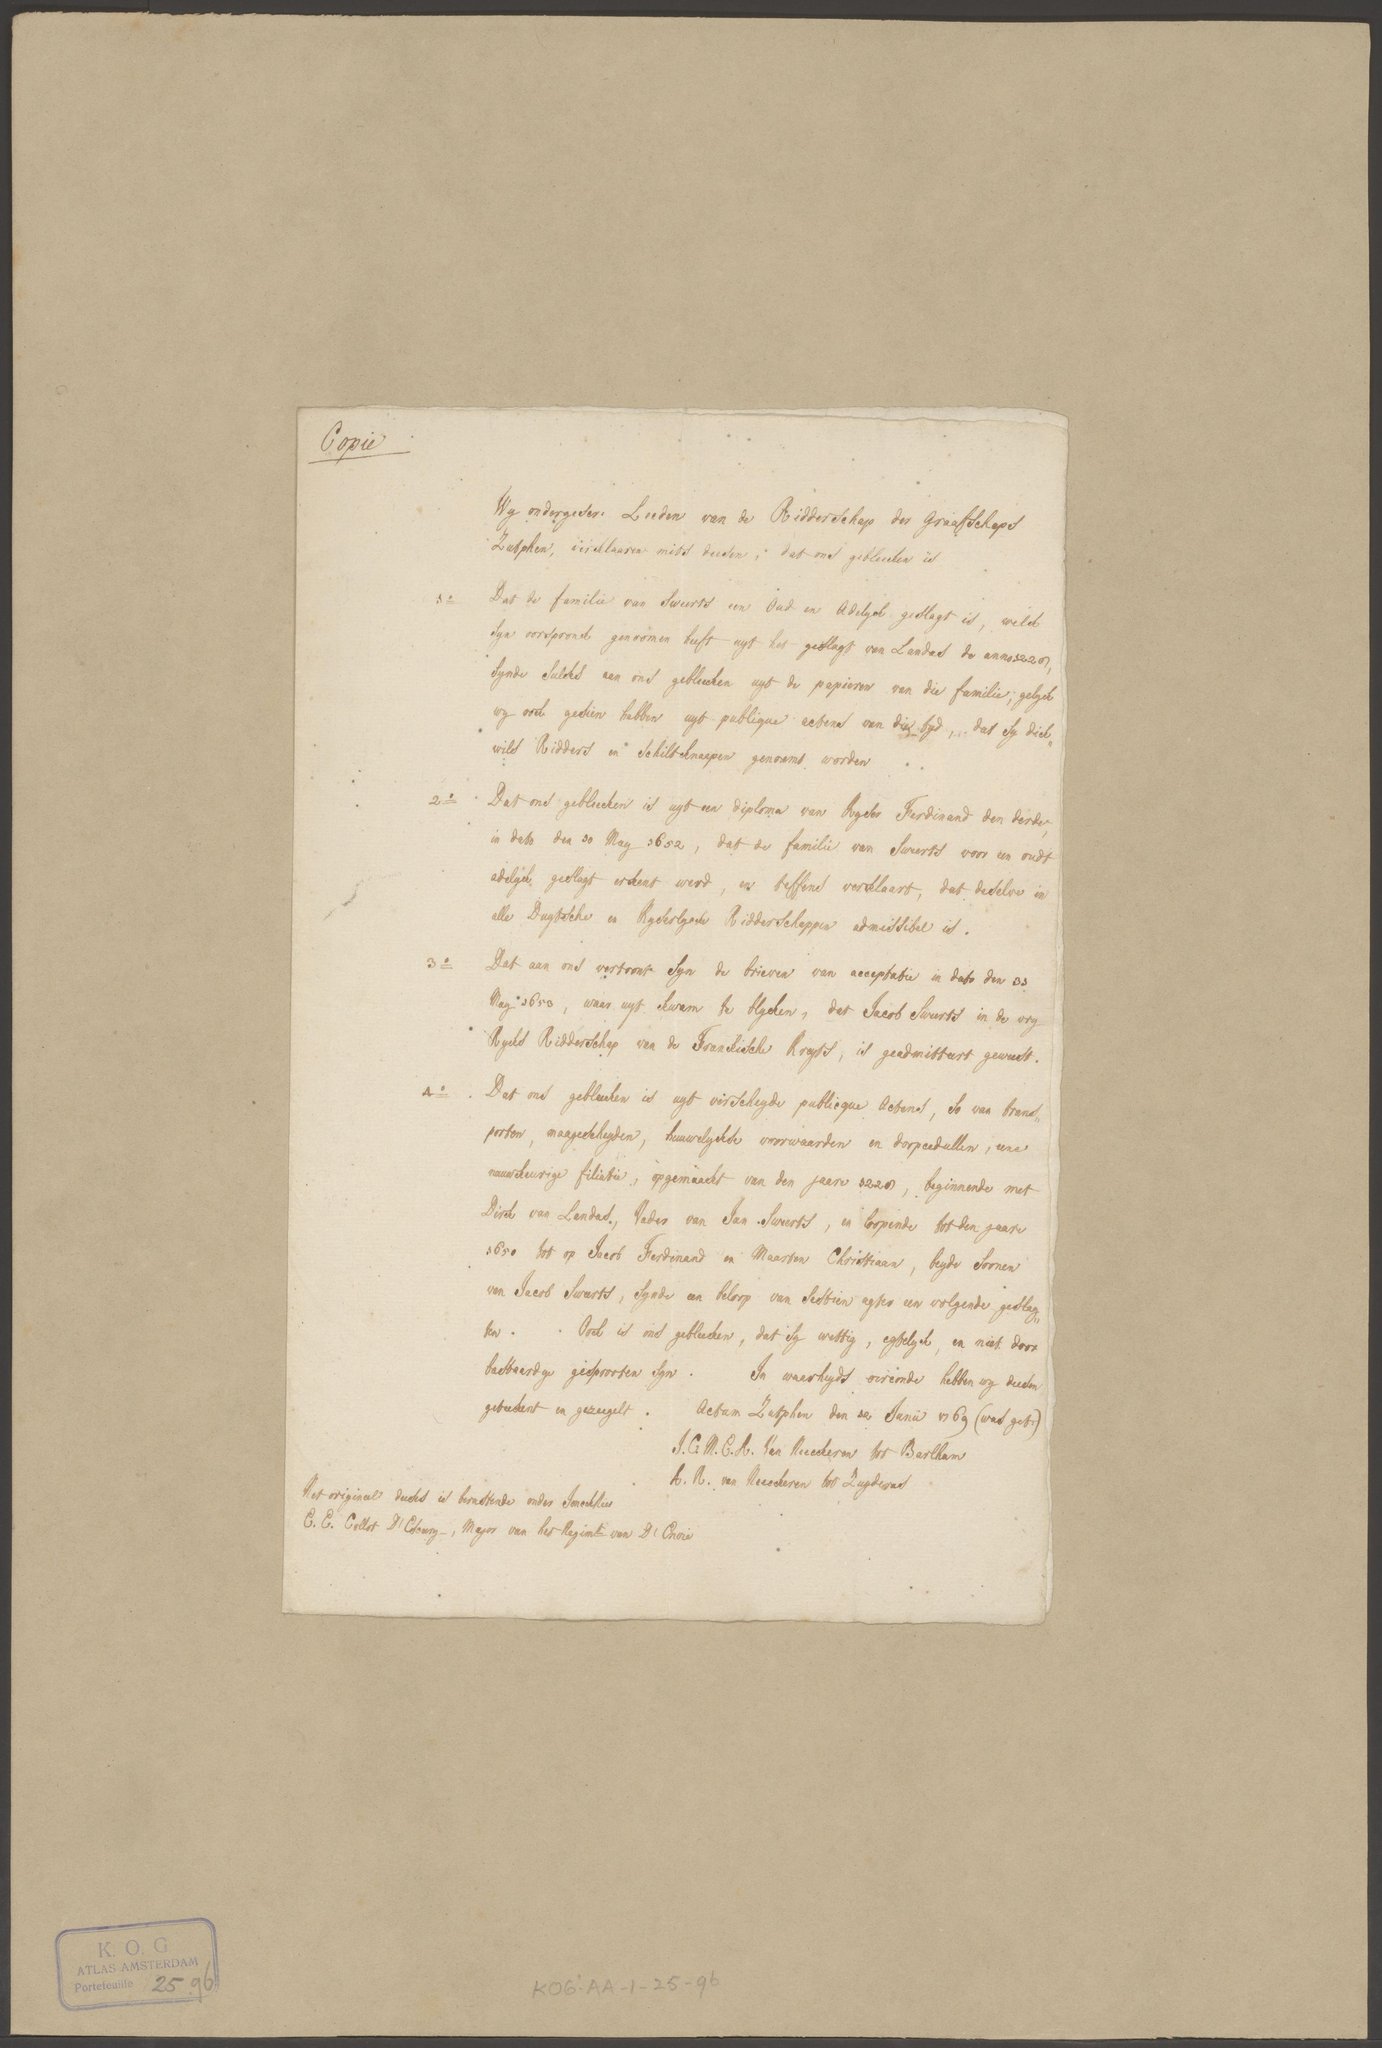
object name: text sheet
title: Kopie van adeldomverklaring van familie Sweerts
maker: Anonymous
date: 1769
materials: ink, paper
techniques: pen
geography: zutphen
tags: the hague, nobility and patriciate; chivalry, knighthood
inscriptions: signature: ‘I.C.M.C.A. Van Neeckeren tot Barlham’, signature: ‘A.A. van Neeckeren tot Zuydera[...]’, collector's mark: ‘25.96’ Lugt 1641b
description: Handgeschreven kopie van een verklaring van de adeldom van de familie Sweerts, uitgegeven door de leden van de Ridderschap van het graafschap Zutphen. Onderwerpsrubriek binnen de Atlas Amsterdam: Krijgswezen I: De Admiraliteit van Amsterdam, B. Vlootvoogden en schepelingen; Herinneringen daaraan.